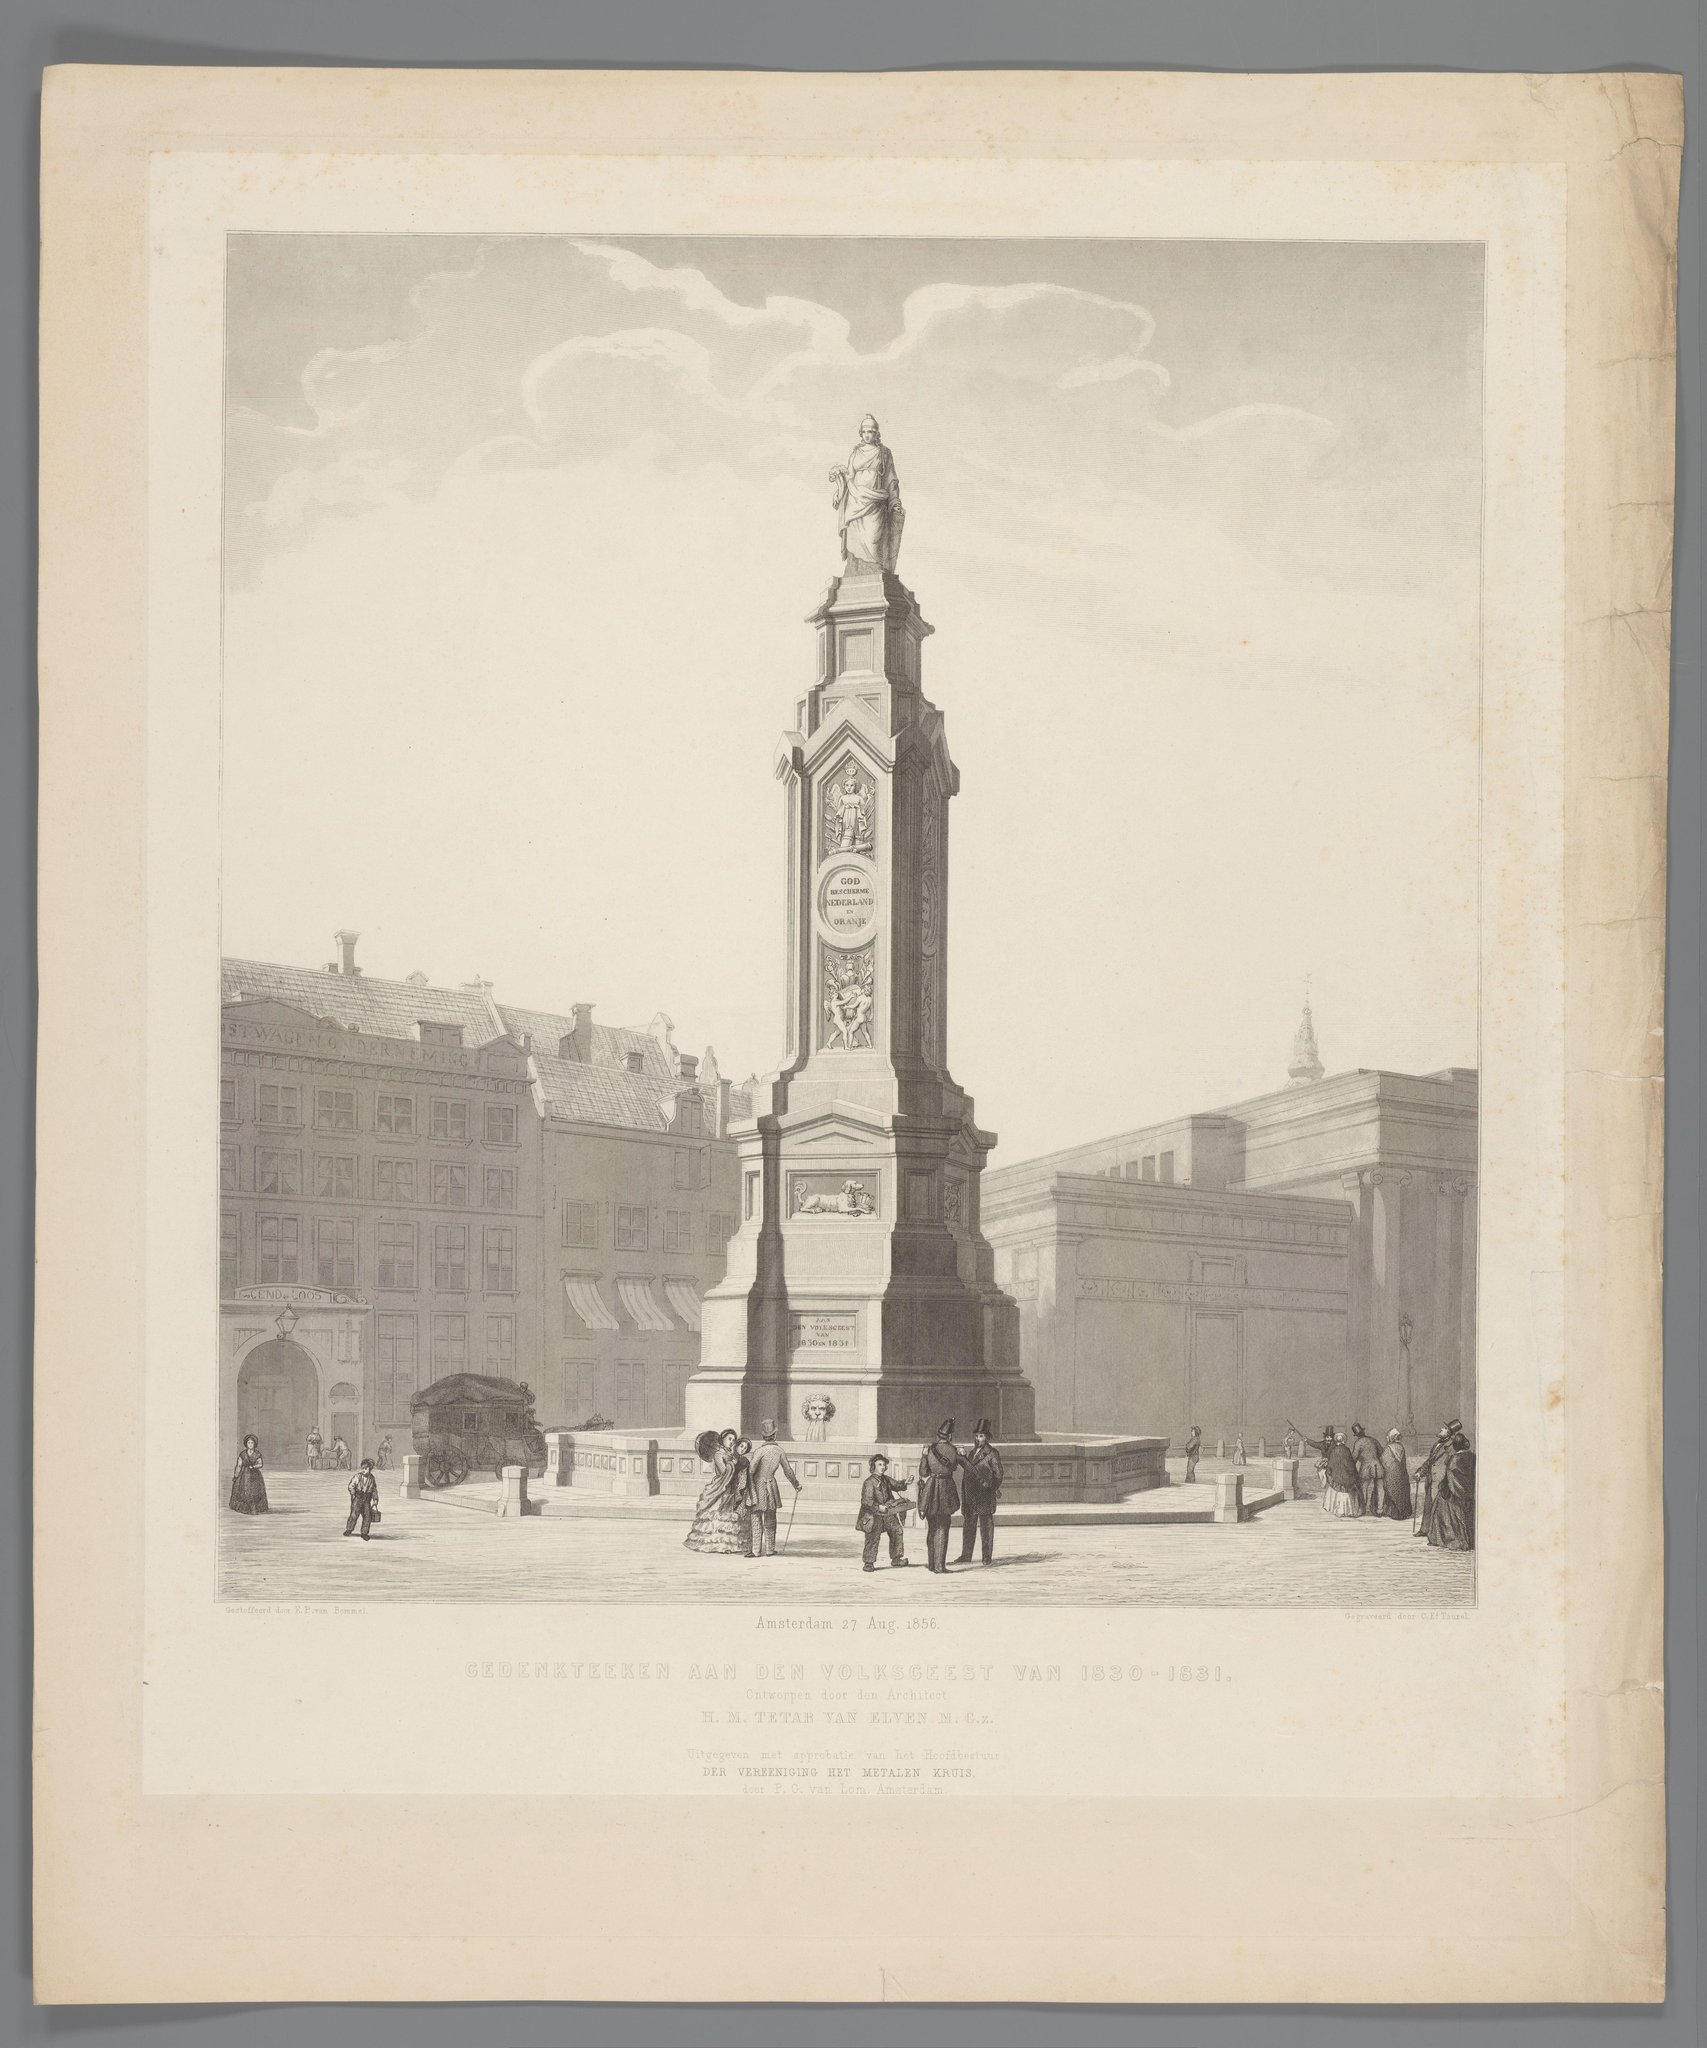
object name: print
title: Gedenkteken aan de volksgeest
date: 1856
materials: paper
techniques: engraving, etching, roulette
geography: netherlands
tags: monument, statue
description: Monument aan de volksgeest van 1830-1831 op de Dam te Amsterdam, ingewijd op 27 augustus 1856.